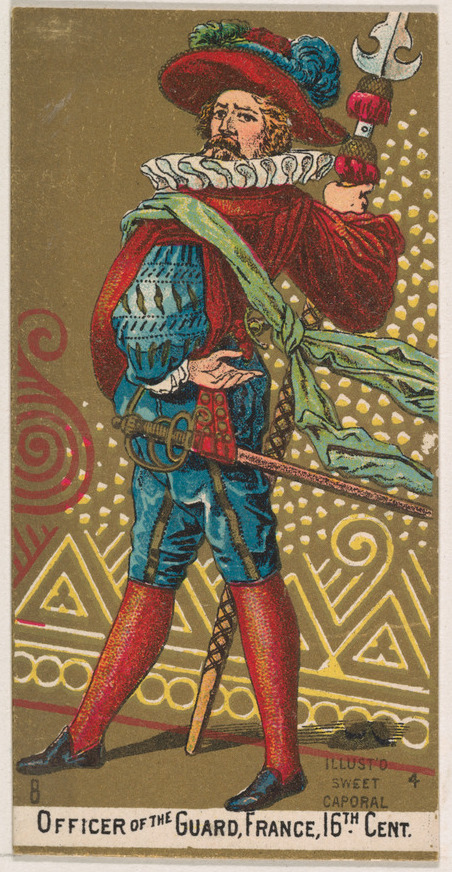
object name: print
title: Officer of the Guard, France, 16th Century, from the Military Series (N224) issued by Kinney Tobacco Company to promote Sweet Caporal Cigarettes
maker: kinney brothers tobacco company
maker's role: publisher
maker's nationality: american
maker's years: 1869-2011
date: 1888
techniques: color lithograph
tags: military,men